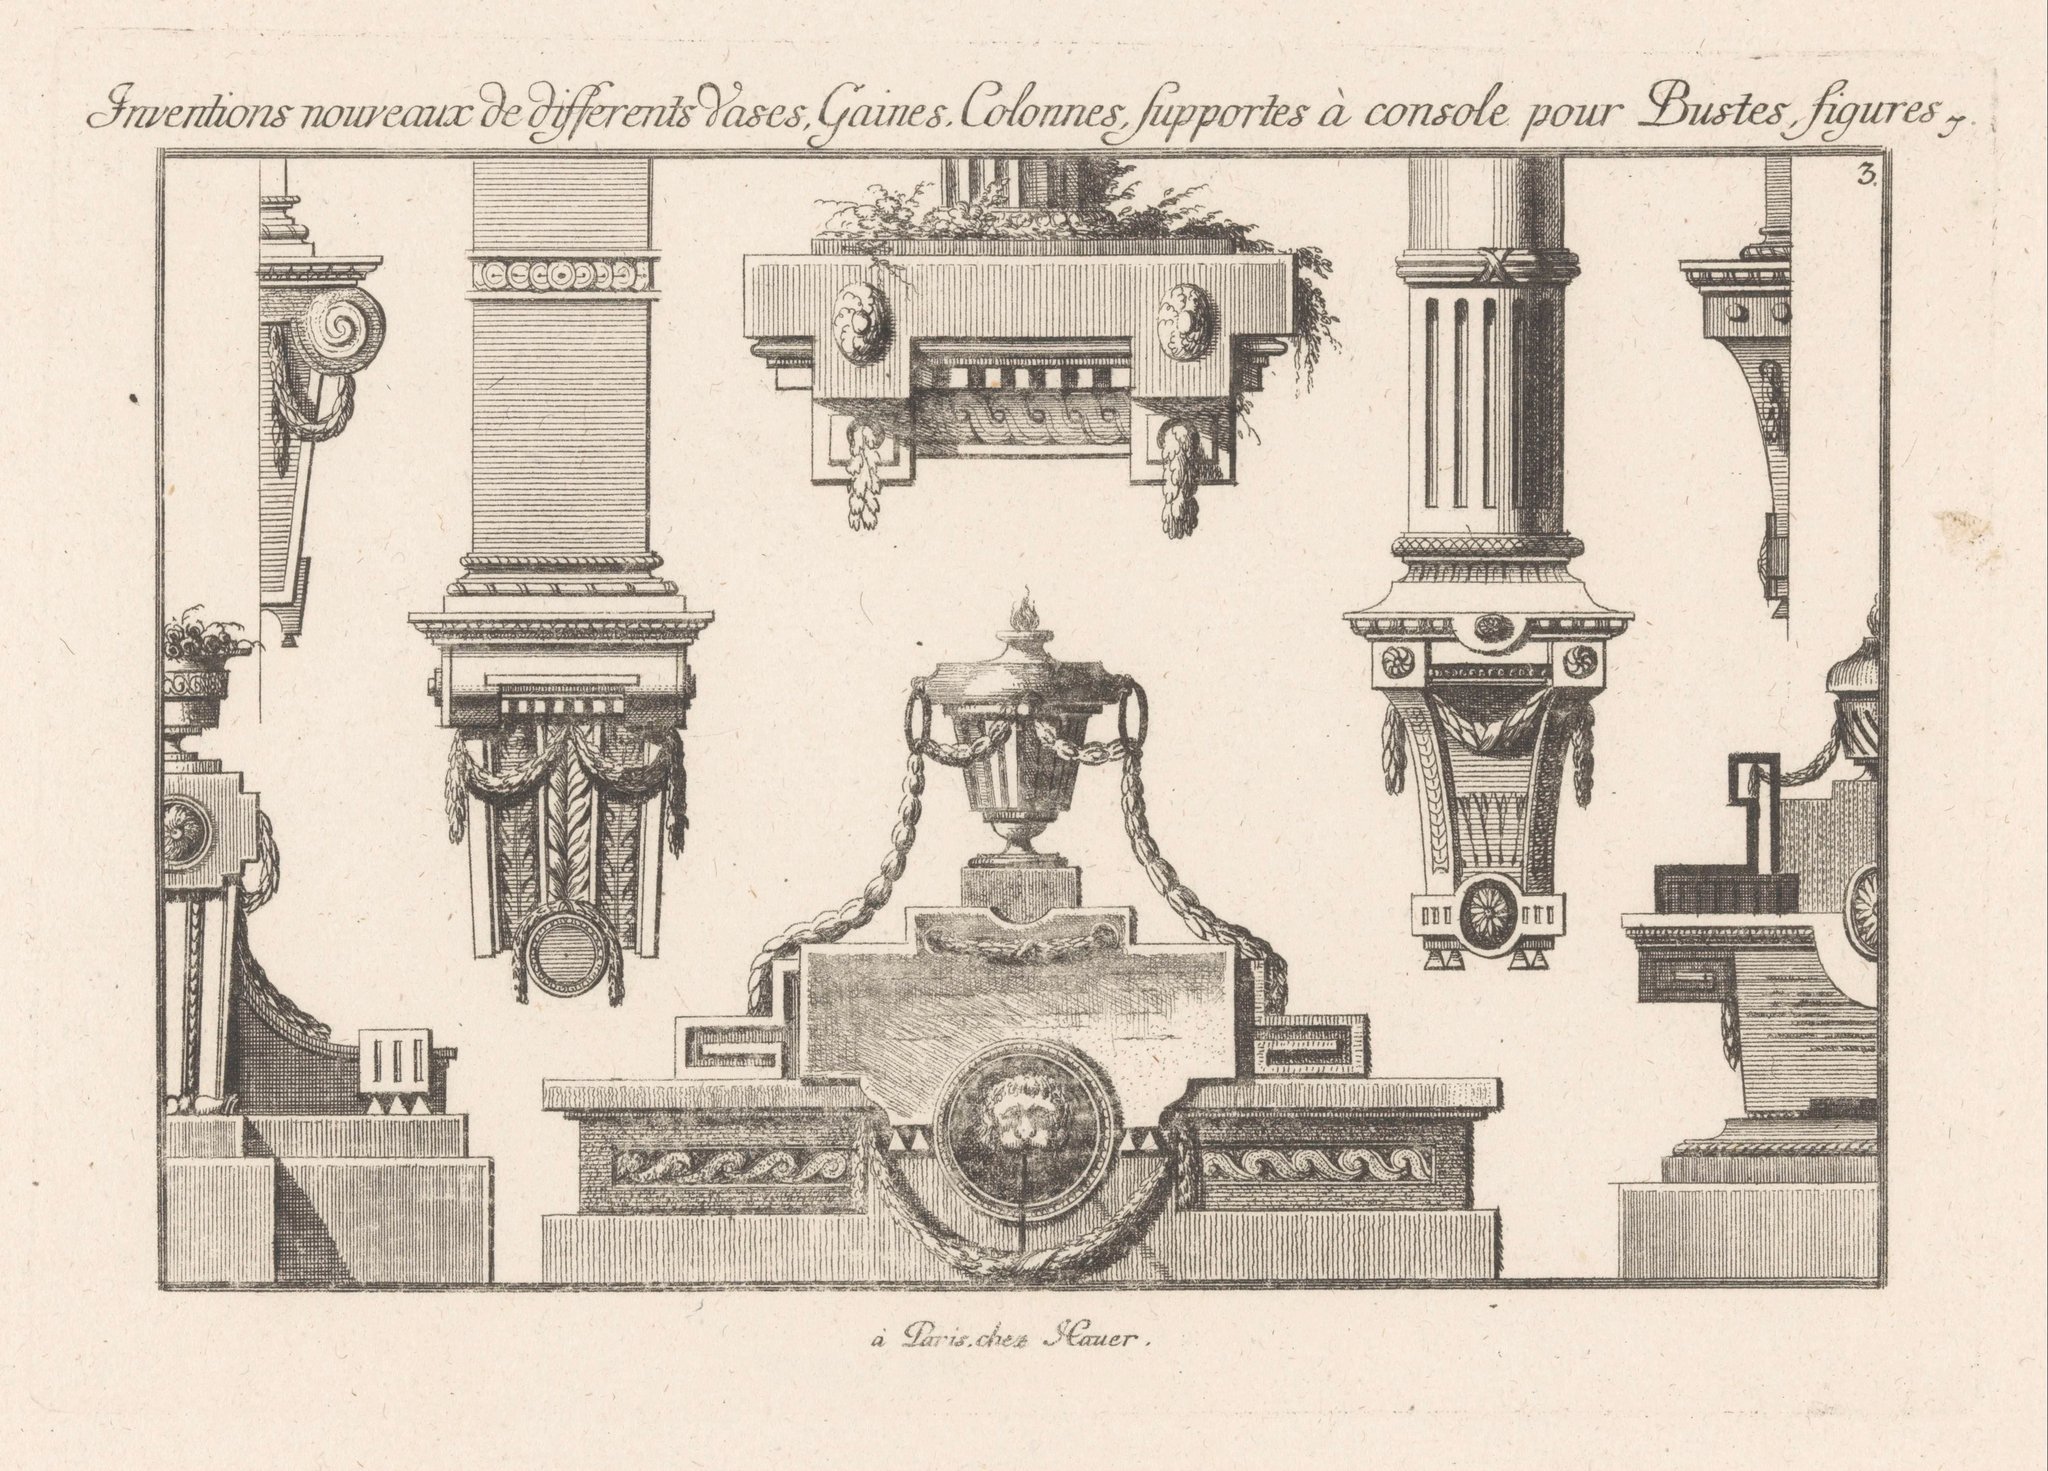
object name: ornament print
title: Inventions nouveaux de differents Vases (...)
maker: johann thomas hauer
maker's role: print maker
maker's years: 1748-1820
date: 1781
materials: paper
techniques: etching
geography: paris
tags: pedestal of a piece of sculpture (perhaps in the form of a herm), architecture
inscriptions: collector's mark: Lugt 2760, collector's mark: Lugt 2228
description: Vijf onderzijdes van voetstukken en drie bouwwerken met vazen en guirlandes.